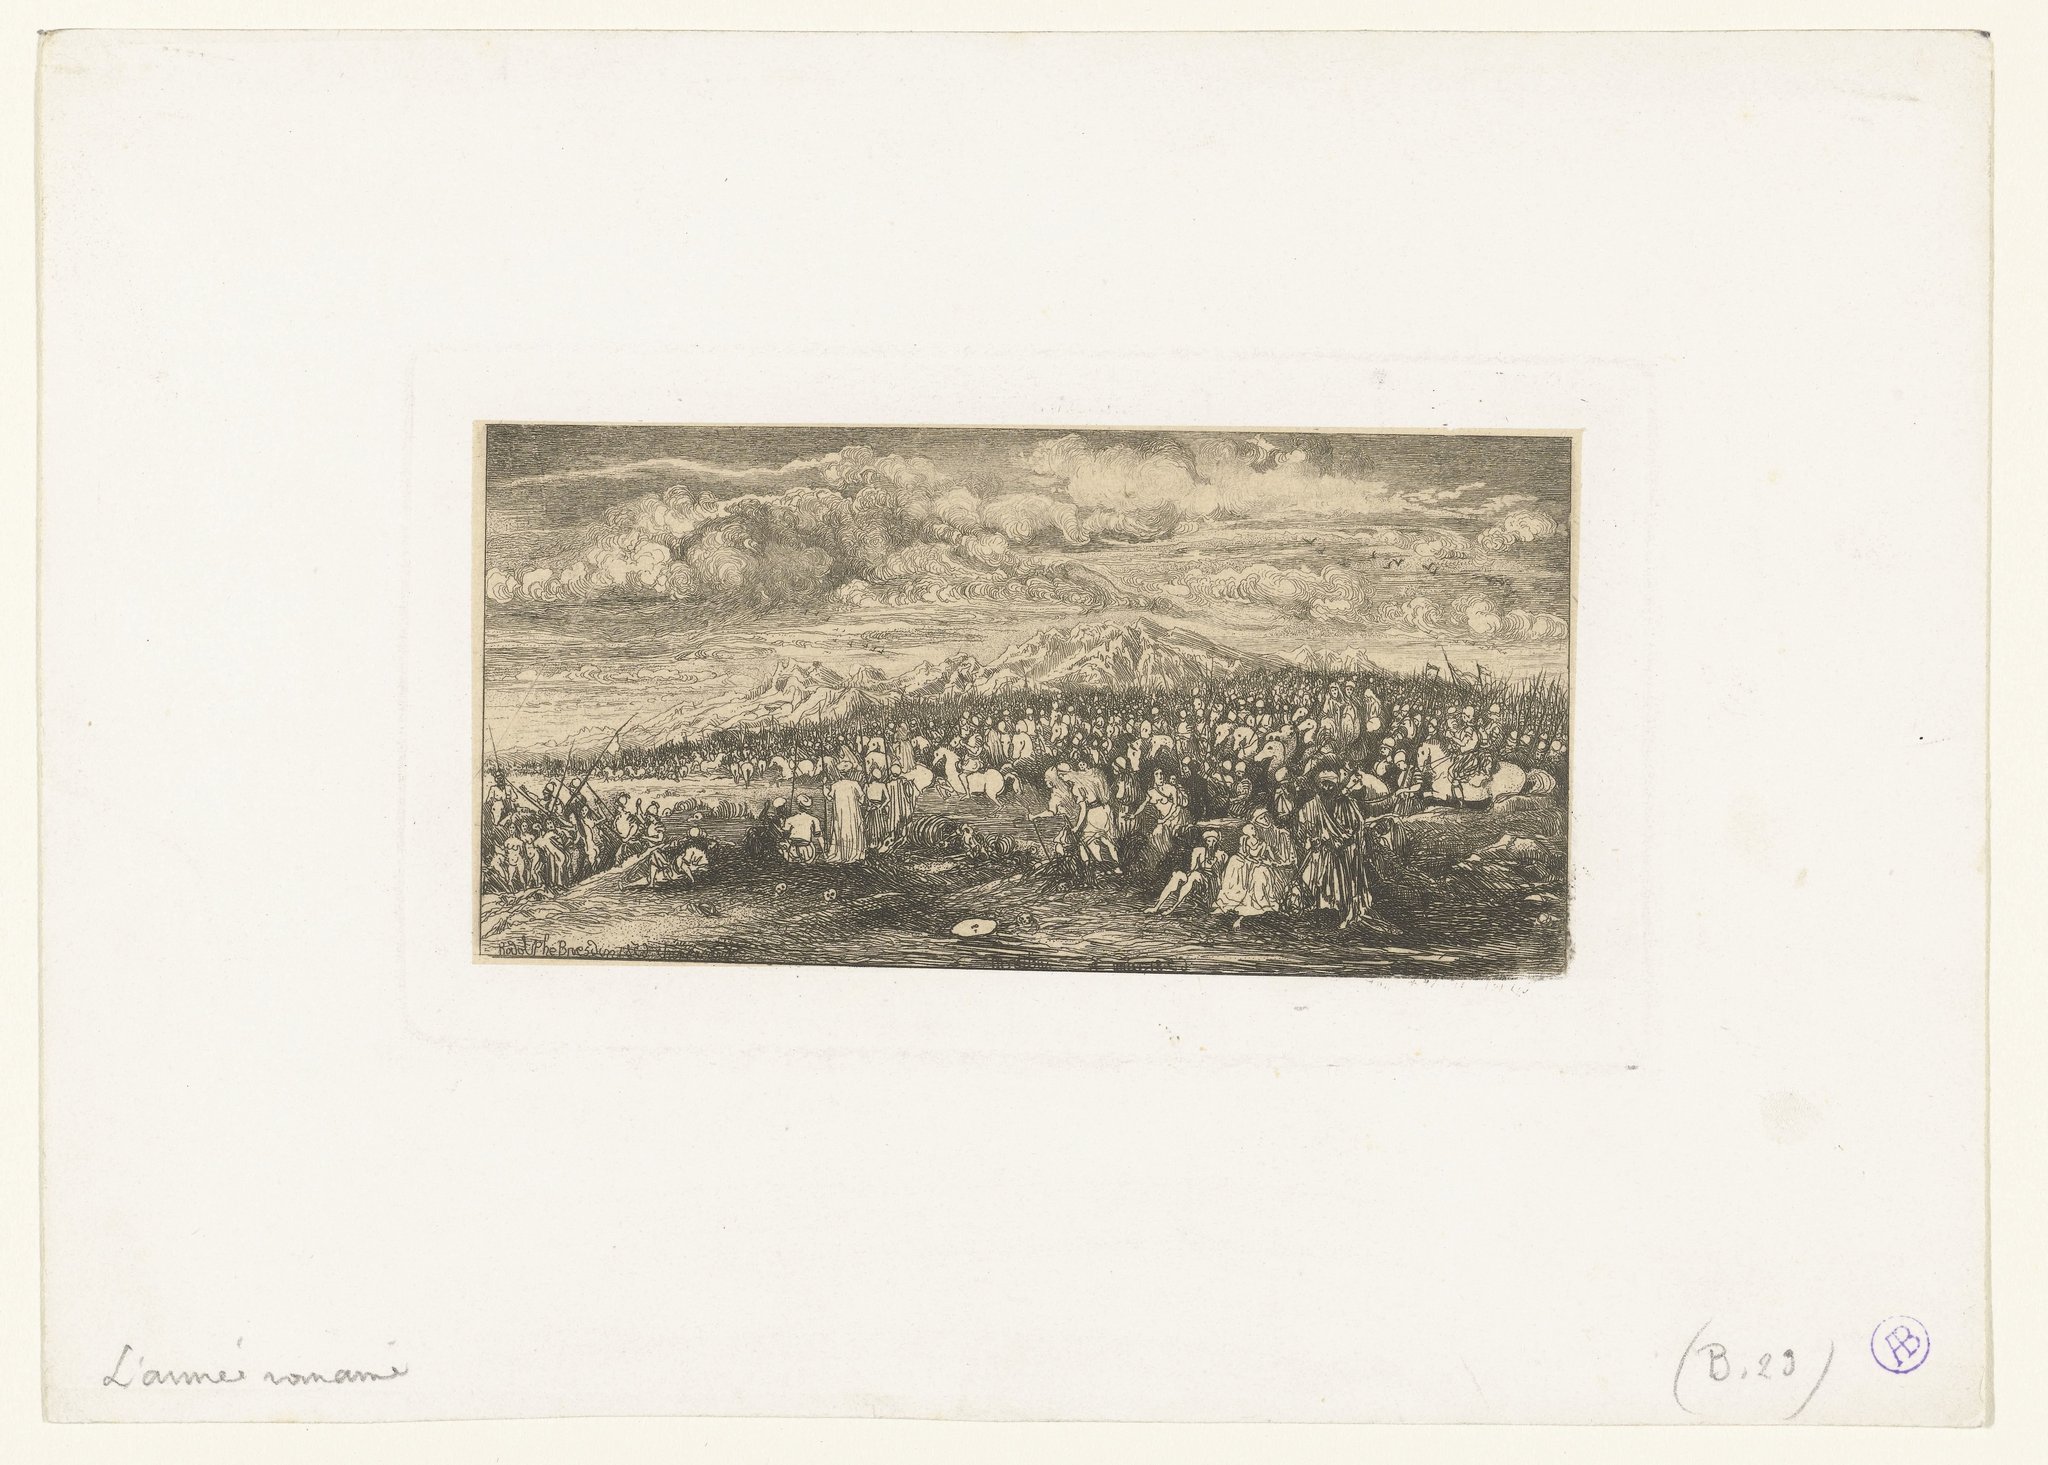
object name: print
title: Groot leger rukt op naar links op vlakte in landschap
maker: rodolphe bresdin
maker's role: draughtsman, print maker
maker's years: 1822-1885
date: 1856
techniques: printmaking, etching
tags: battle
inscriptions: collector's mark: Lugt 76, collector's mark: Lugt 2228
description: Een groot leger met veel soldaten te paard rukt op naar links op een vlakte en neemt mensen gevangen.